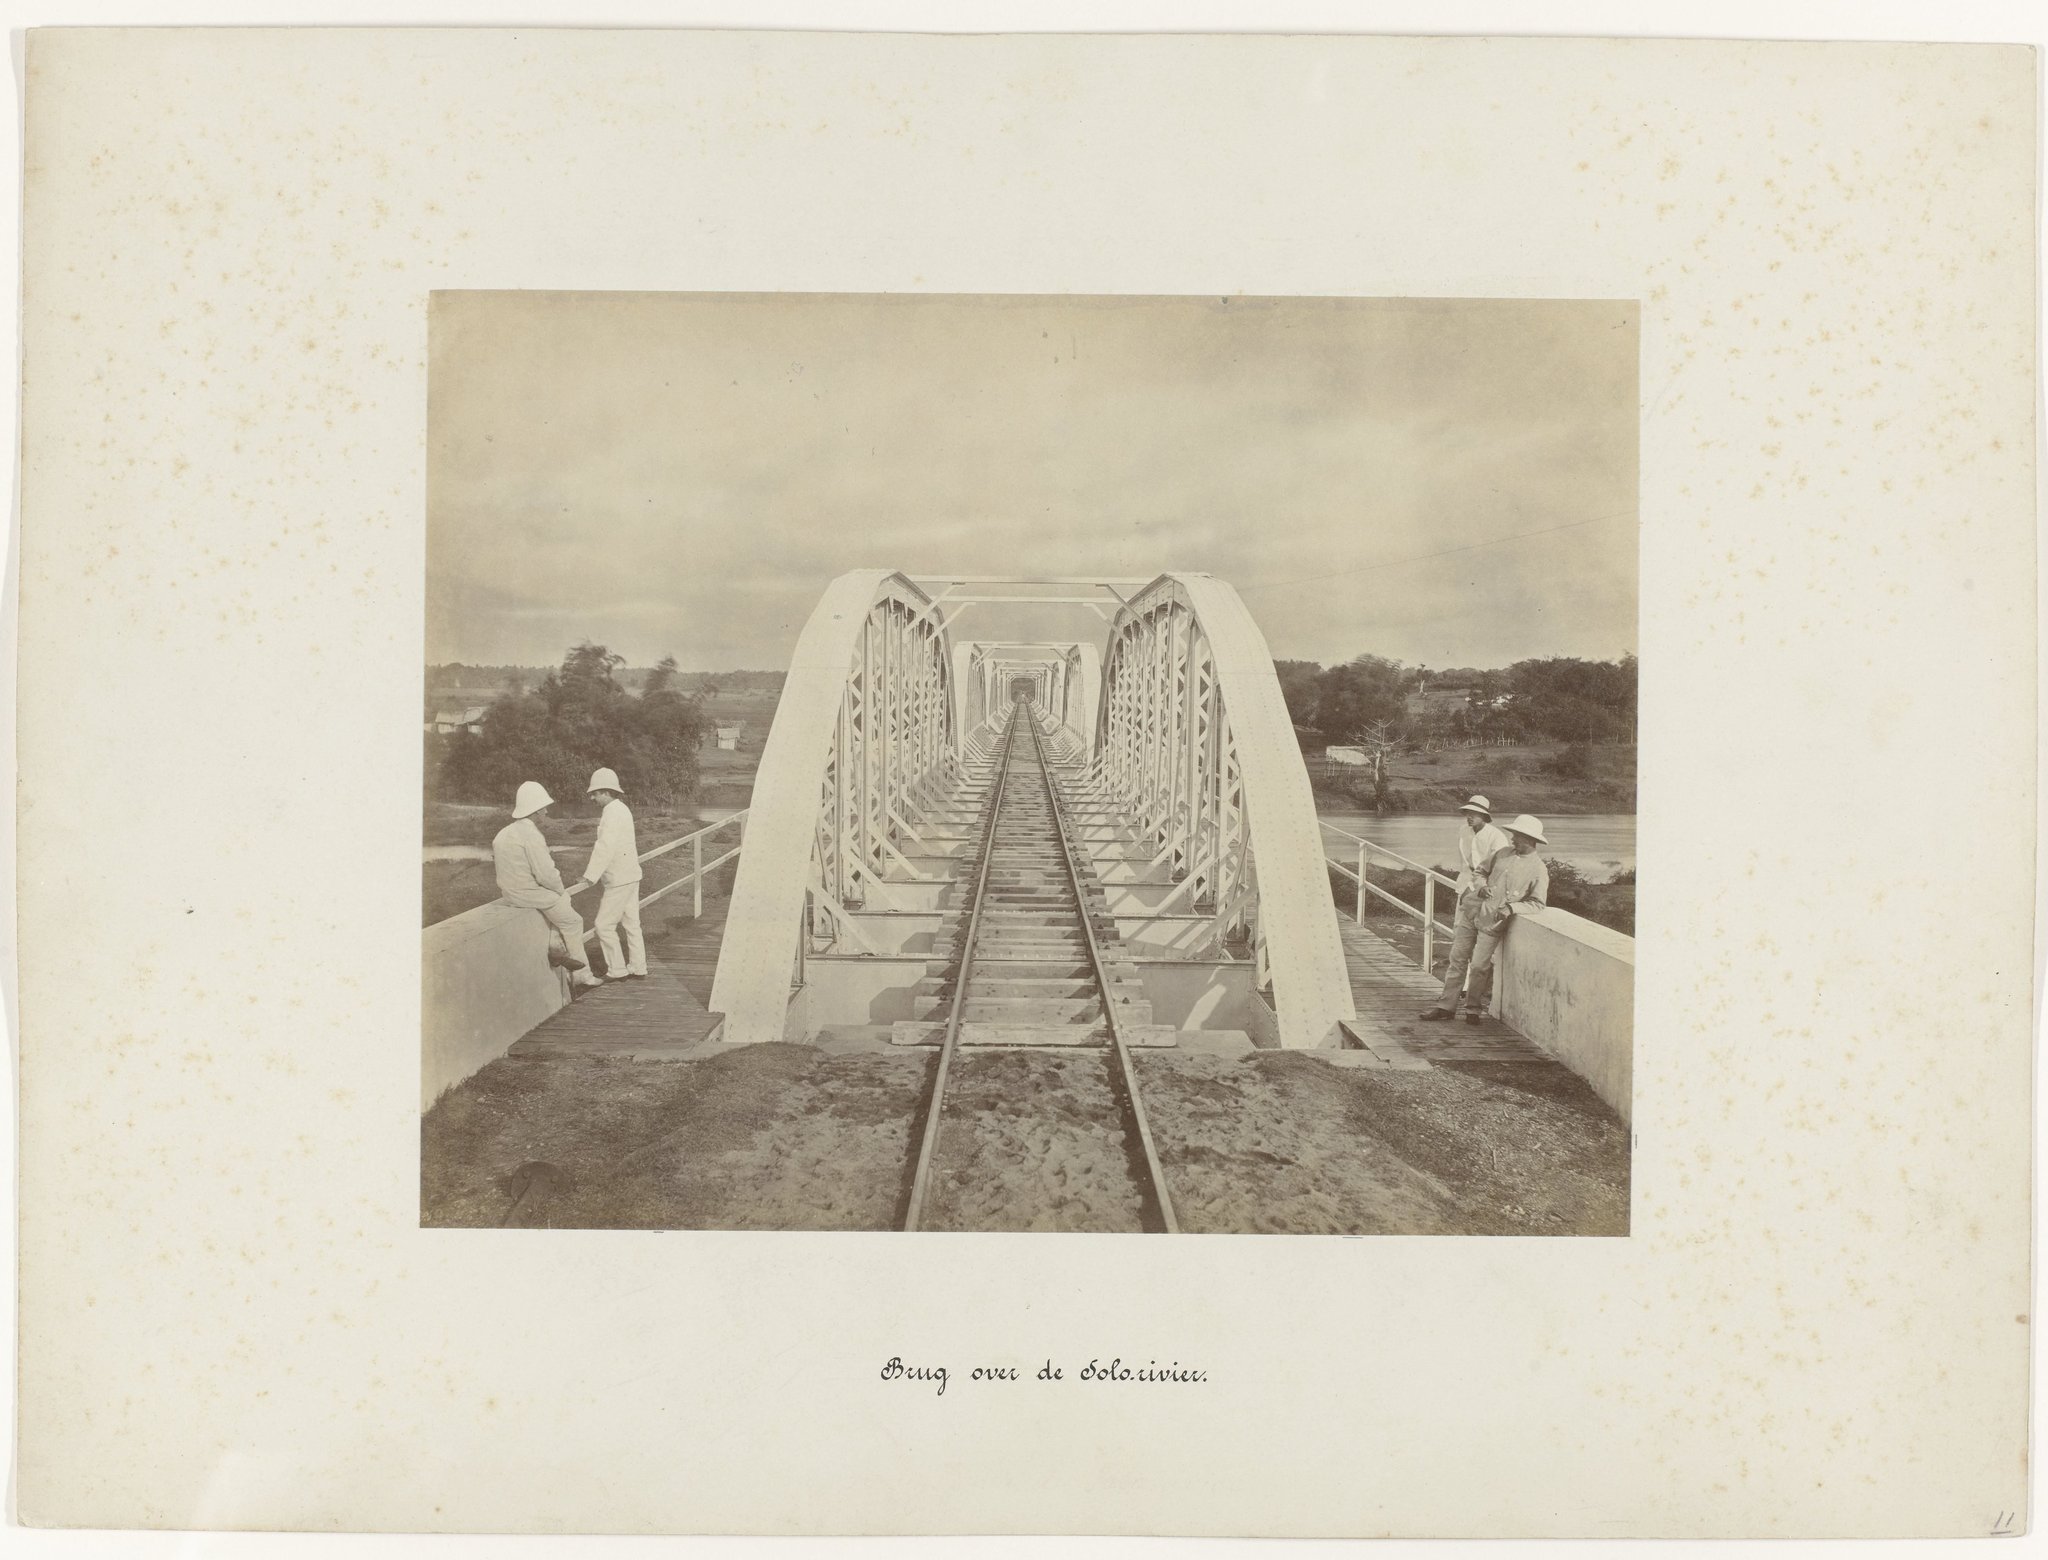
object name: photograph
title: Brug over de Solo rivier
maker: Anonymous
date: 1880-1888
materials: photographic support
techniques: albumen print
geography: java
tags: solo-rivier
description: De brug over de Solo rivier, gezien vanaf het spoor. Op de brug vier mannen. Onderdeel van een groep van 62 foto's in een doos met het opschrift "Staatsspoorwegen op Java" uit 1888.